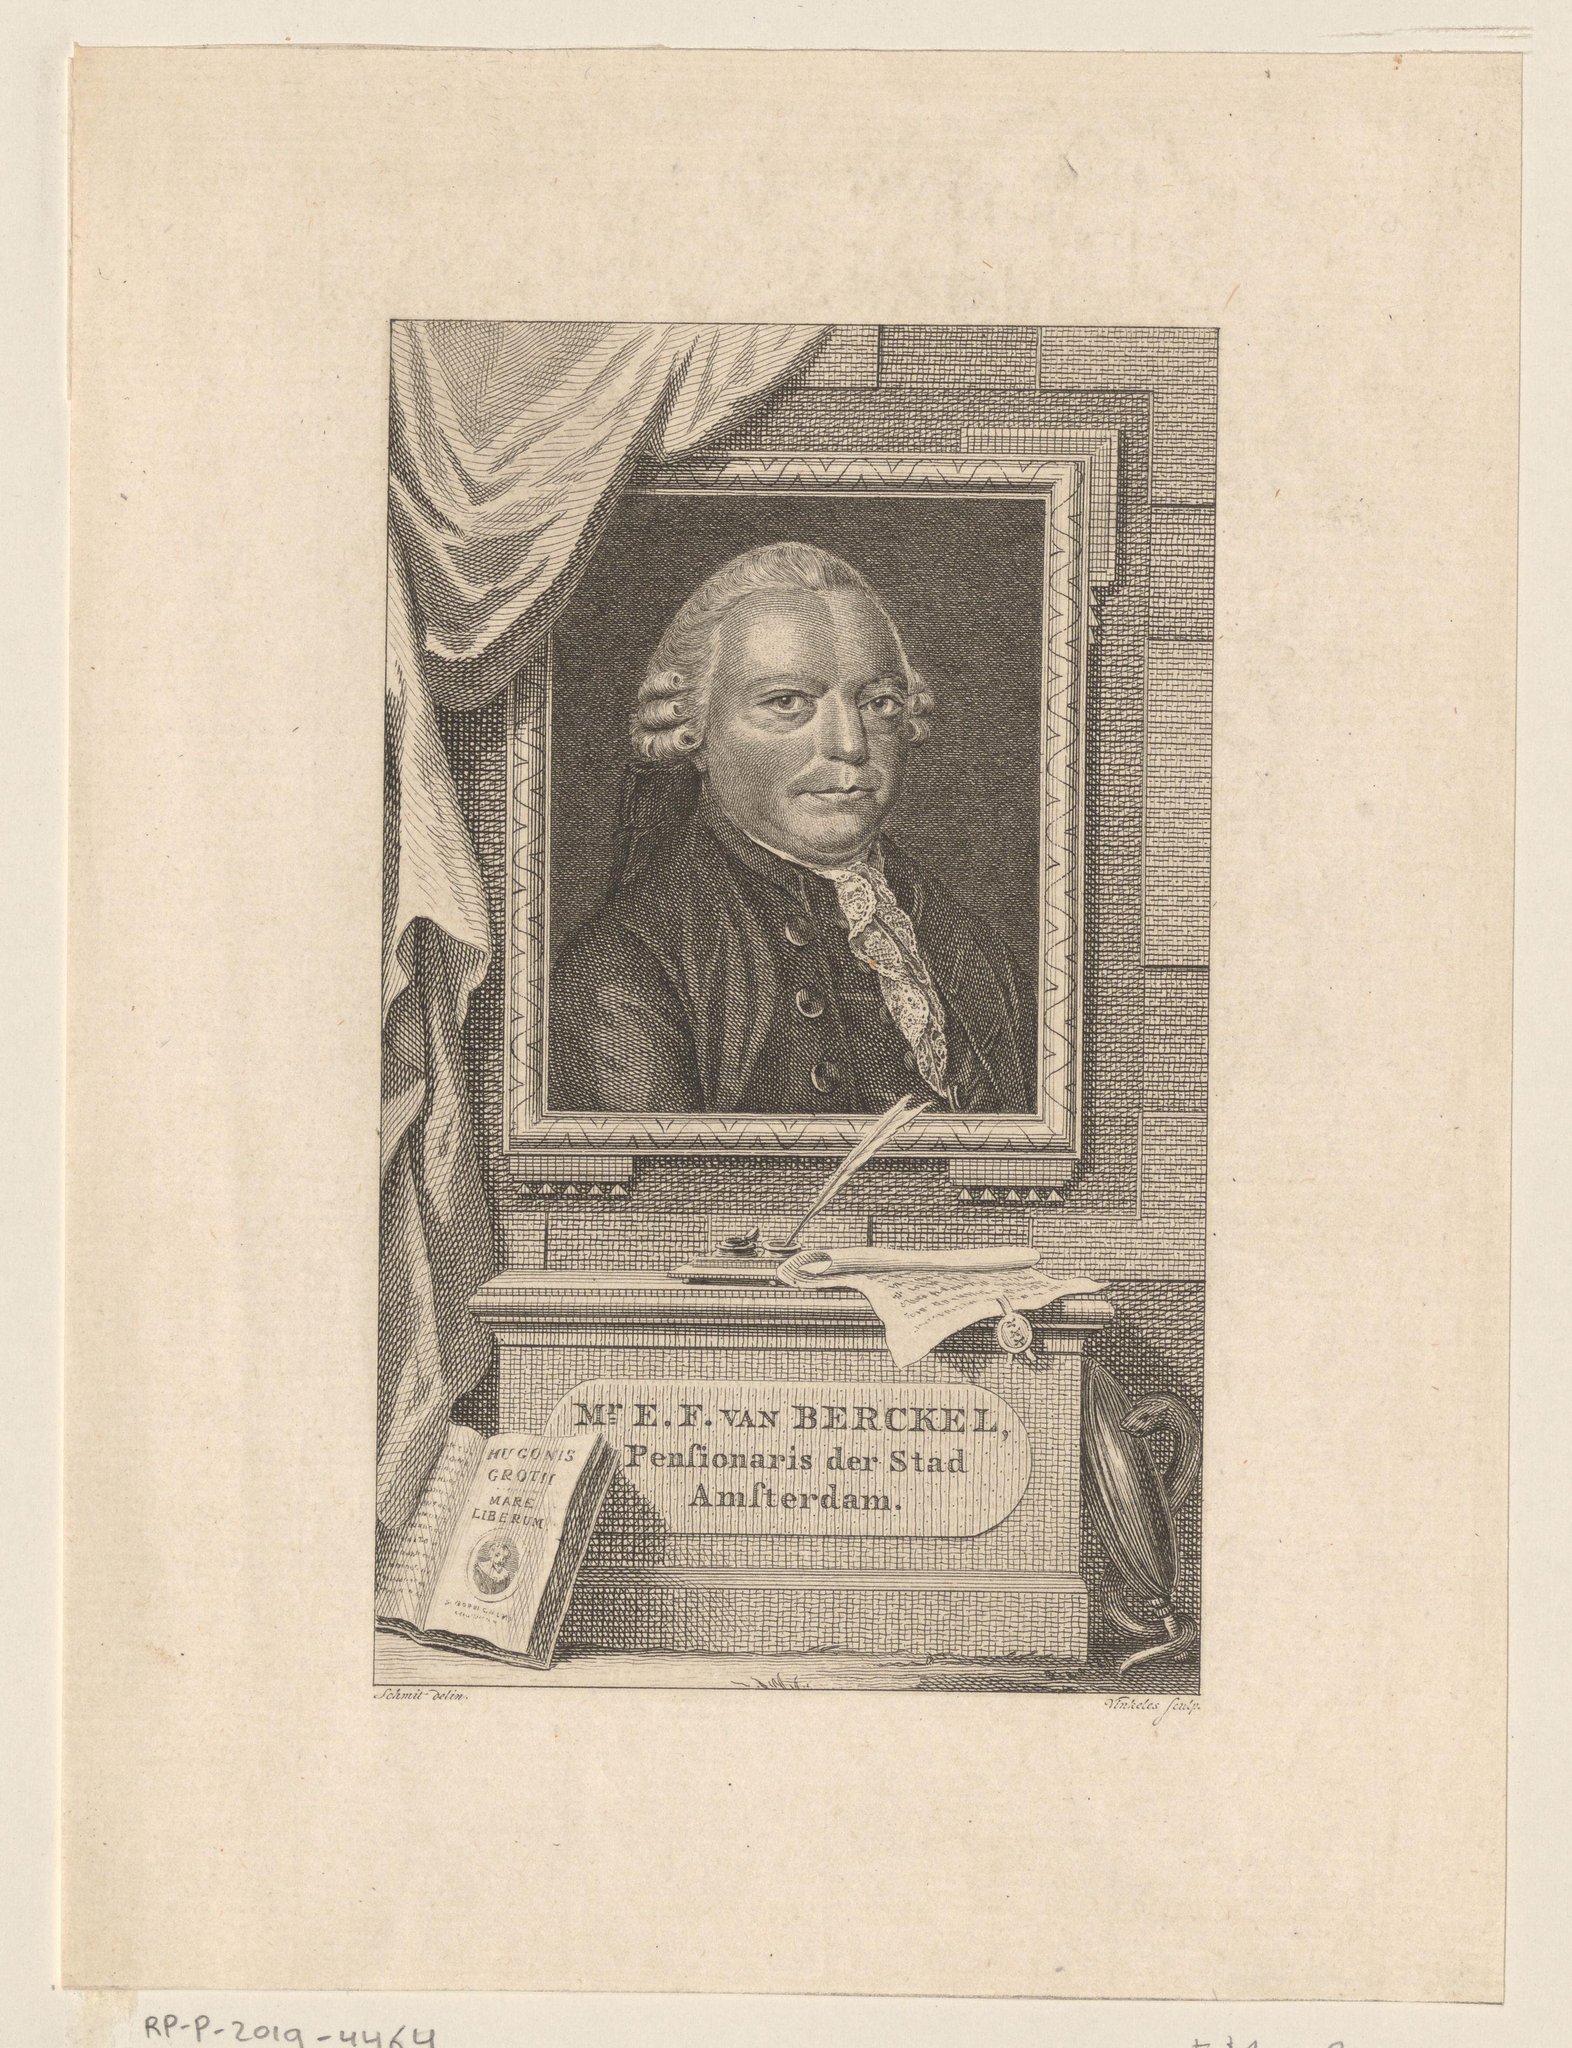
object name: print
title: Portret van Engelbert François van Berckel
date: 1787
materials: paper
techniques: engraving, etching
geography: amsterdam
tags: historical persons, book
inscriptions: collector's mark: Lugt 2228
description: Prent uit: Loosjes, Petrus. Vaderlandsche historie, vervattende de geschiedenissen der Vereenigde Nederlanden (...) ten vervolge van Wagenaars historie. Amsterdam: Johannes Allart, 1787, dl. 2.